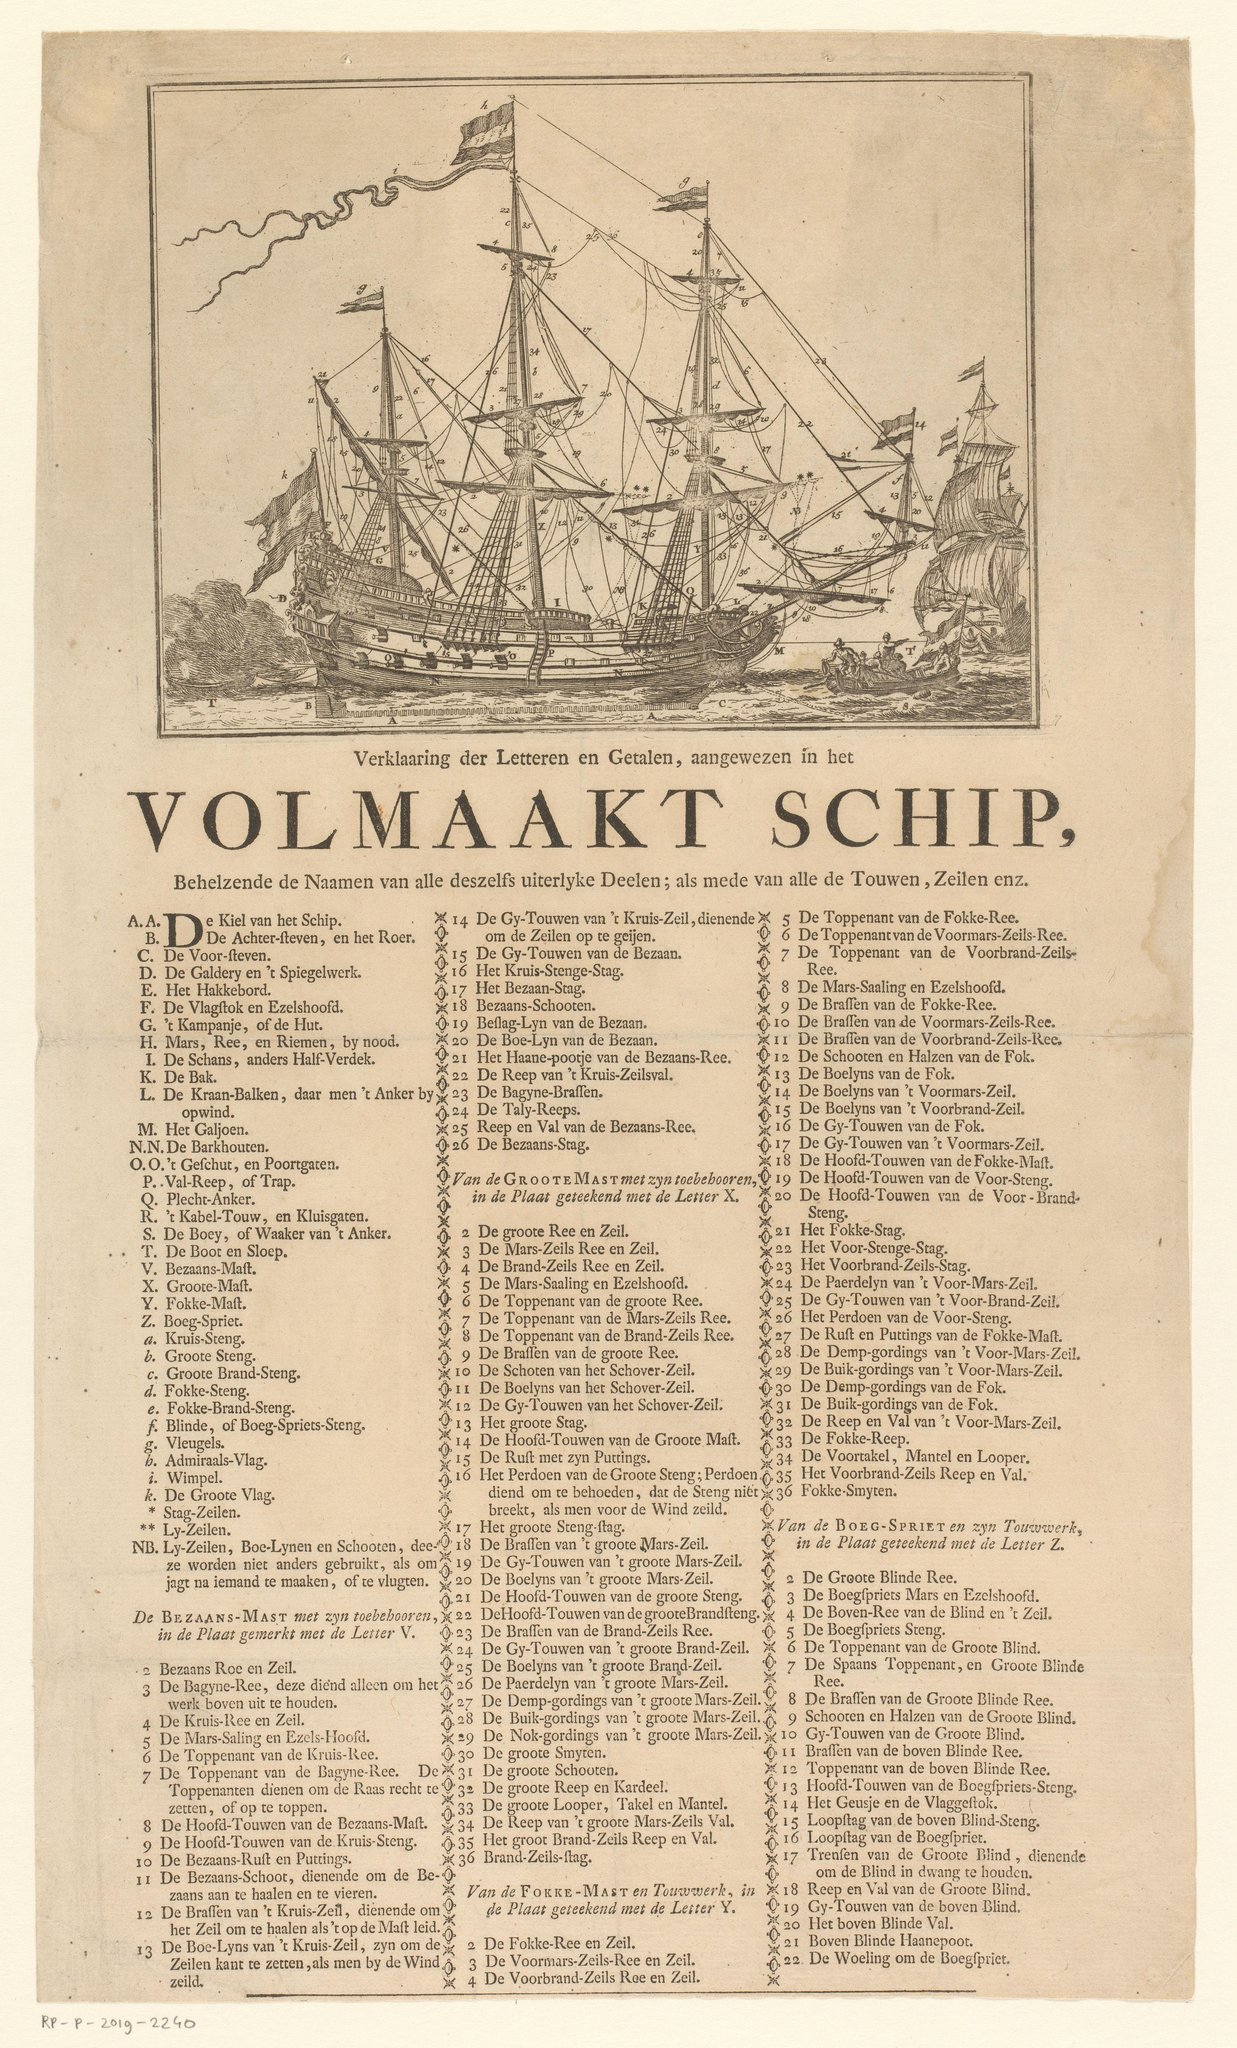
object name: print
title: Volmaakt Schip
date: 1759-1767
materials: paper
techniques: etching, letterpress printing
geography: netherlands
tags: sailing-ship, sailing-boat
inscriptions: collector's mark: Lugt 2228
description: Een volmaakt zeilschip. Onder de voorstelling een legenda.